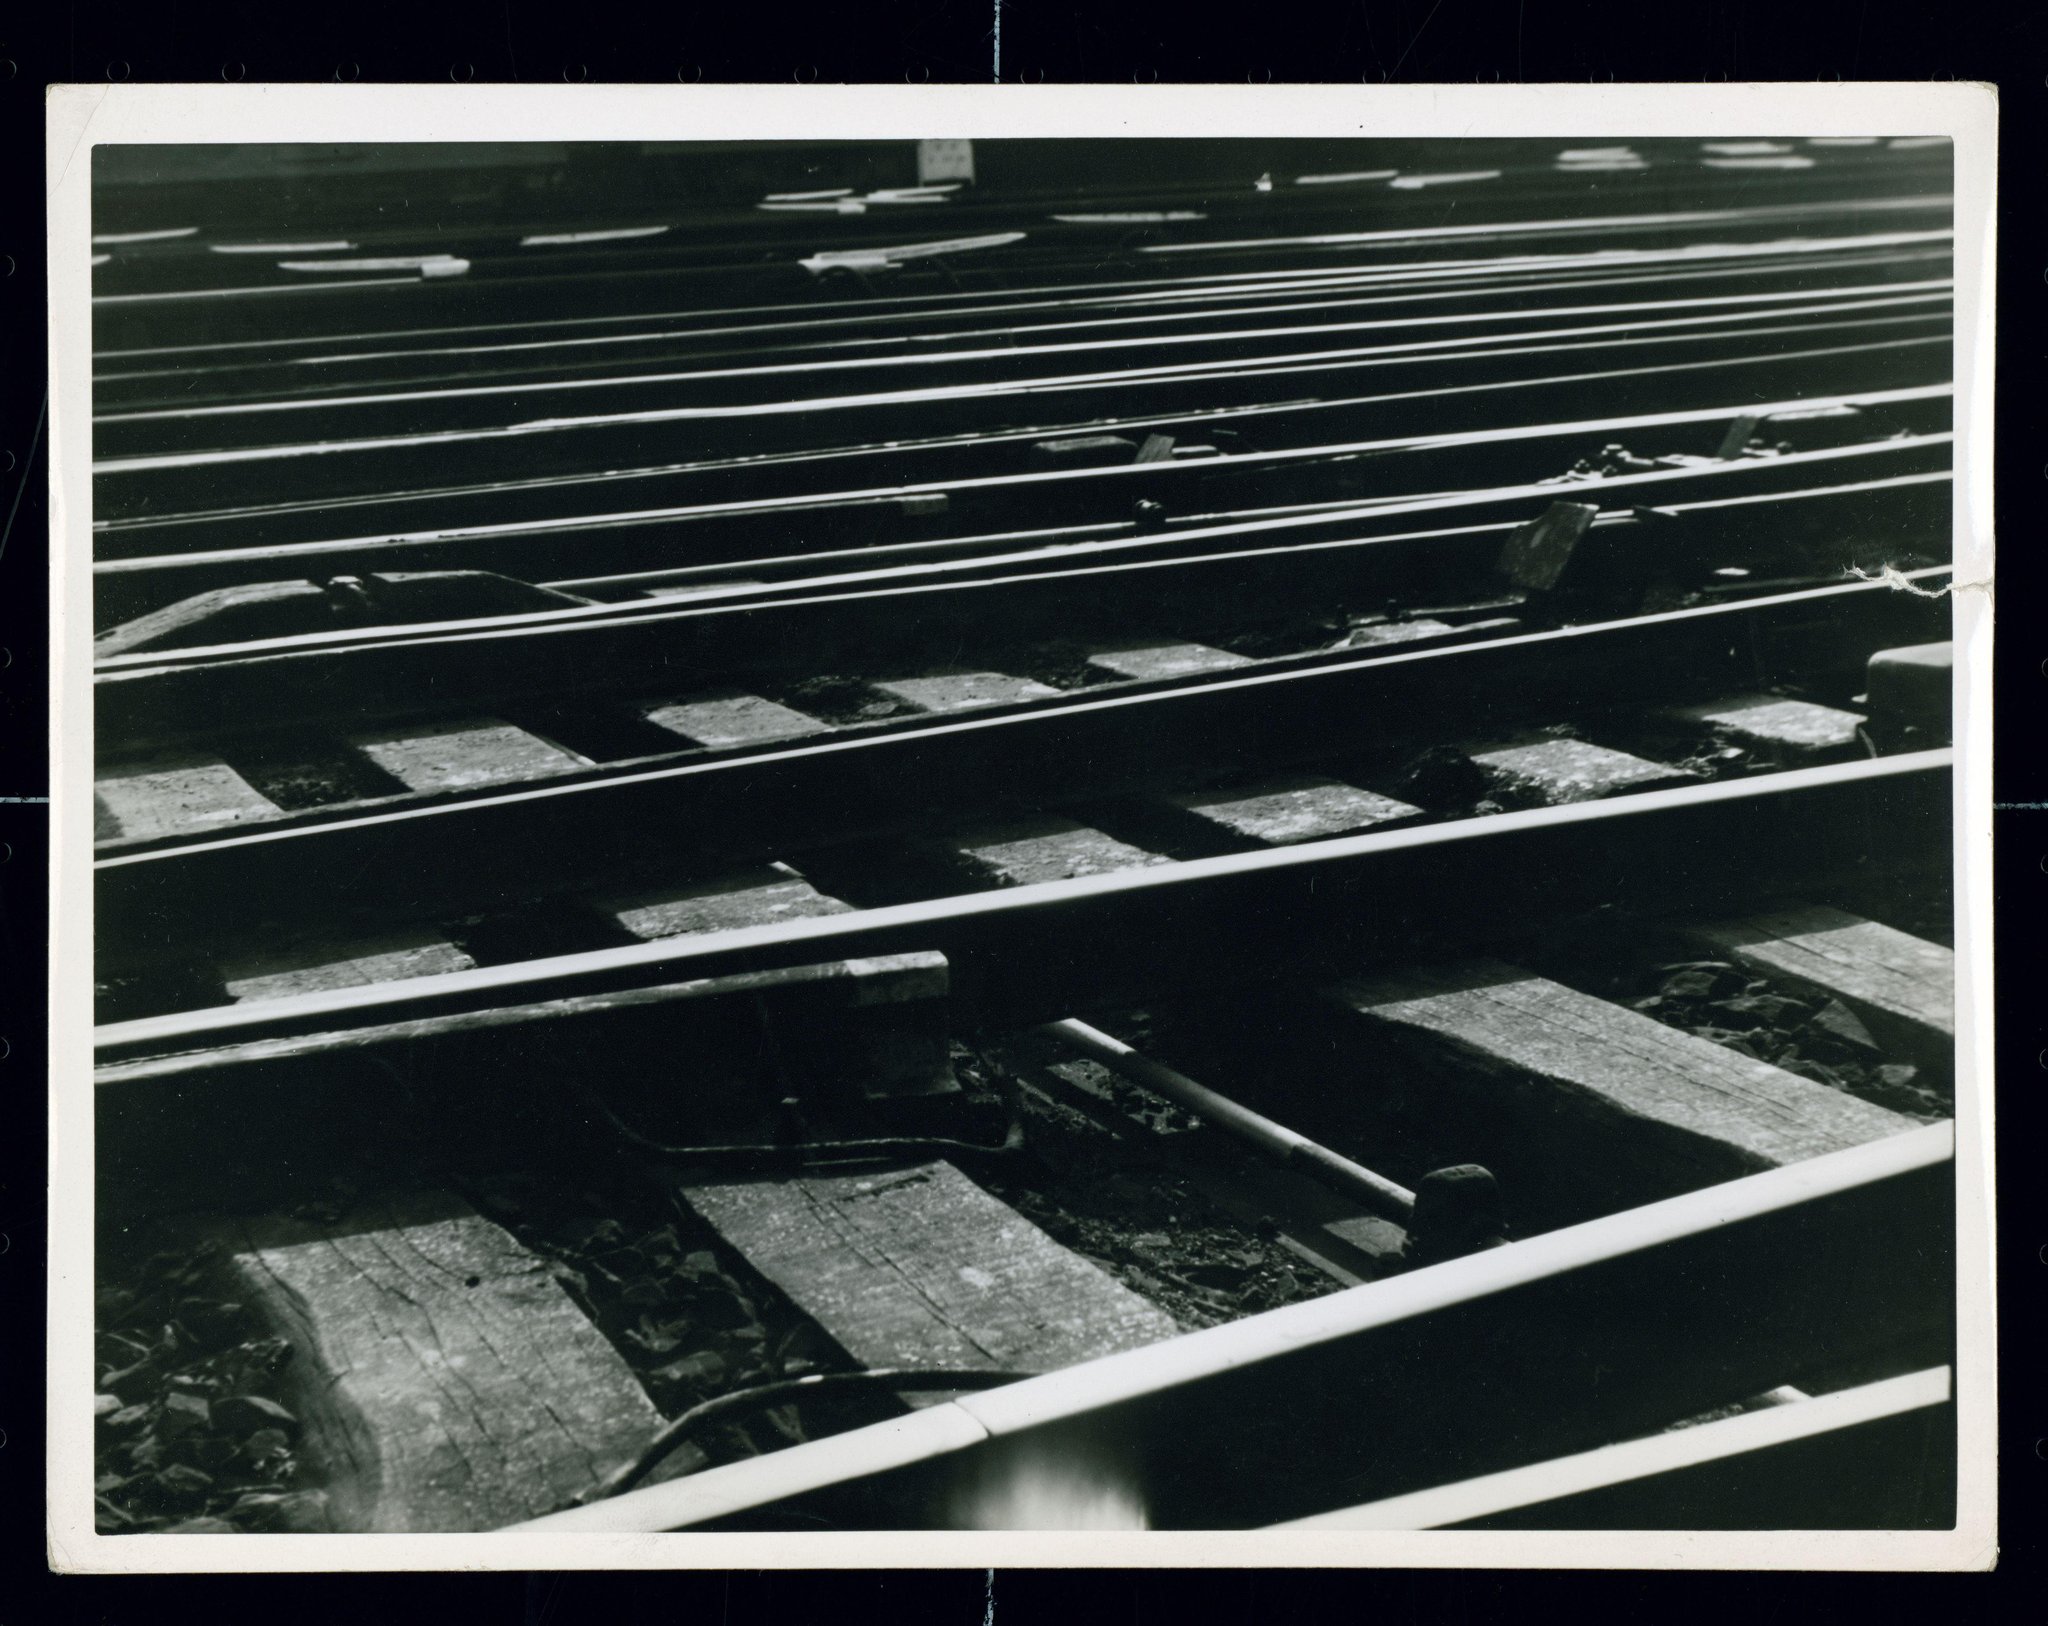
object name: photograph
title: Railway Tracks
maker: guy le boyer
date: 1930-1940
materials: paper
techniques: gelatin silver print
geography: france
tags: railway, tramway; rack railway, france